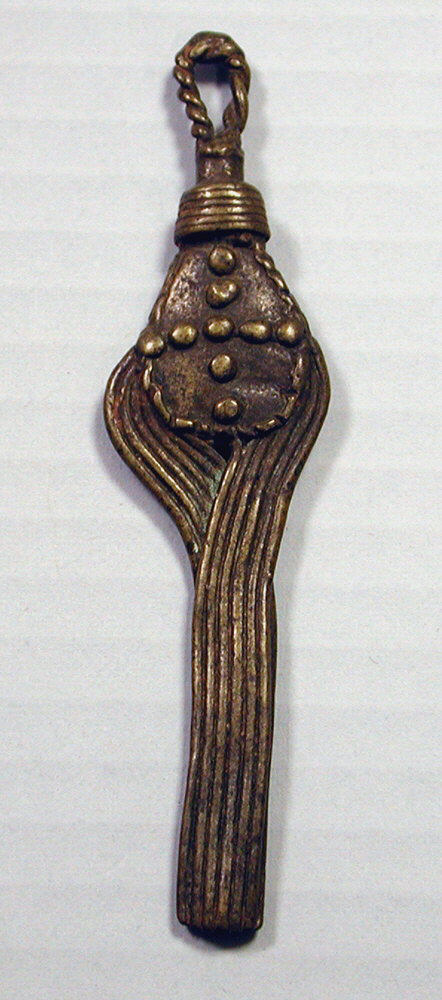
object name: weight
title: Gold Weight: Ceremonial Whisk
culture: akan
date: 1701-1900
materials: brass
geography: ghana